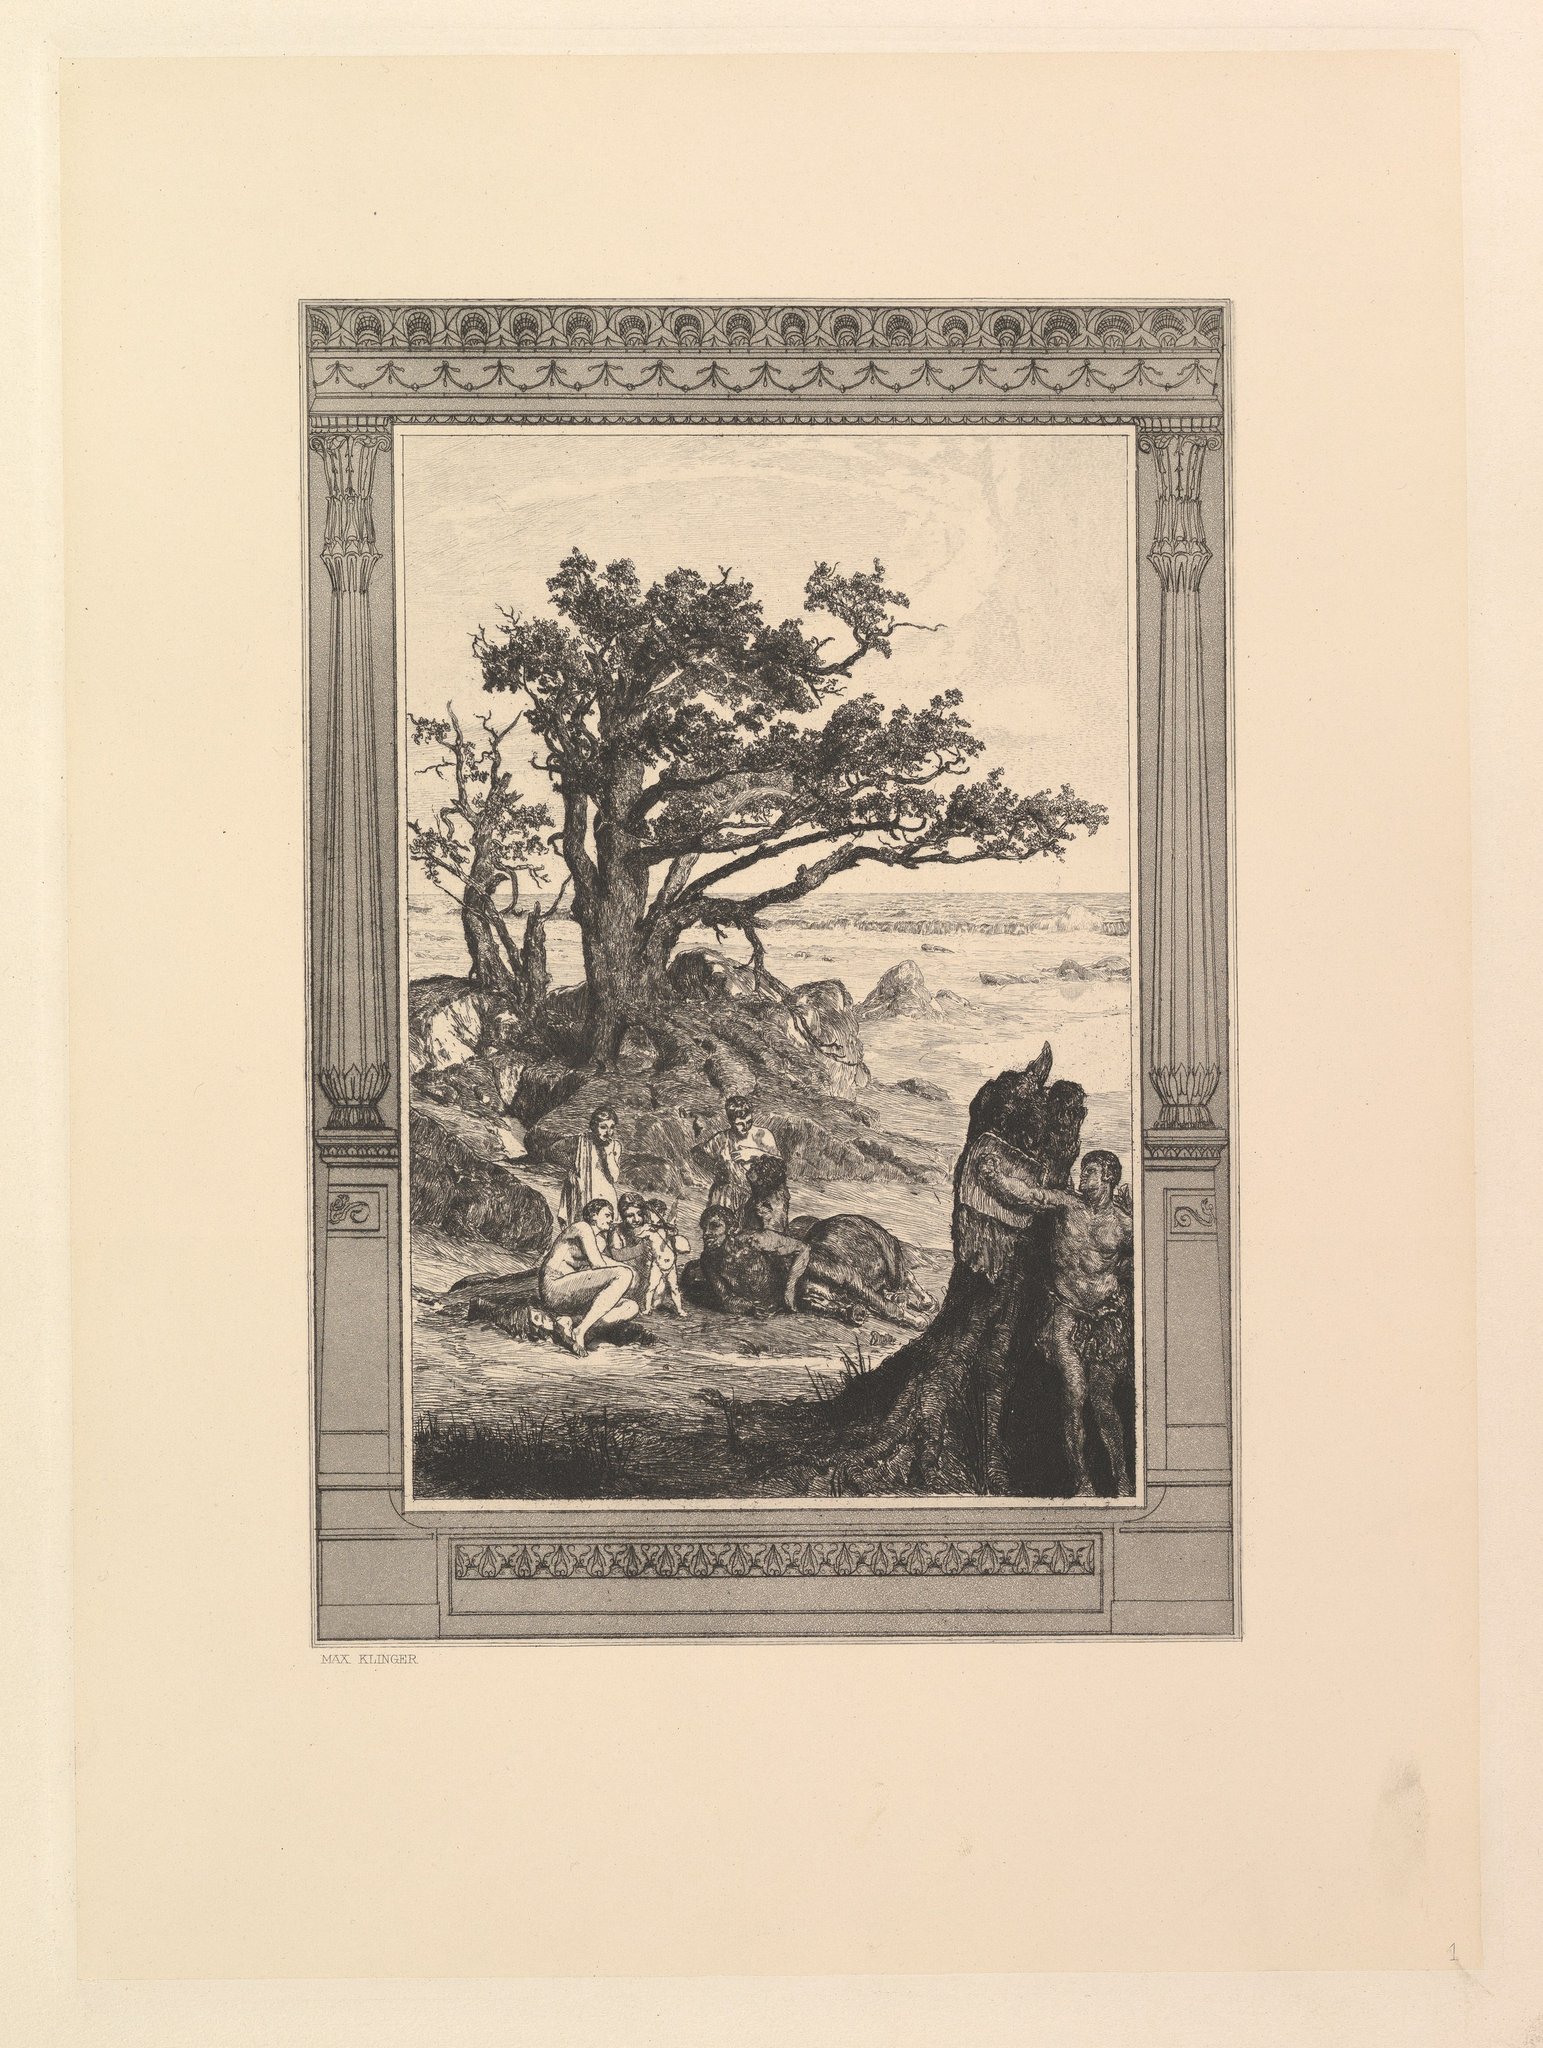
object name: portfolio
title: Max Klinger's Radierungen zu Apulejus' Märchen Amor und Psyche, Opus V a+b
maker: max klinger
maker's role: artist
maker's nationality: german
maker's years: 1857-1920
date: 1909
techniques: aquatint, etching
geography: germany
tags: psyche,trees